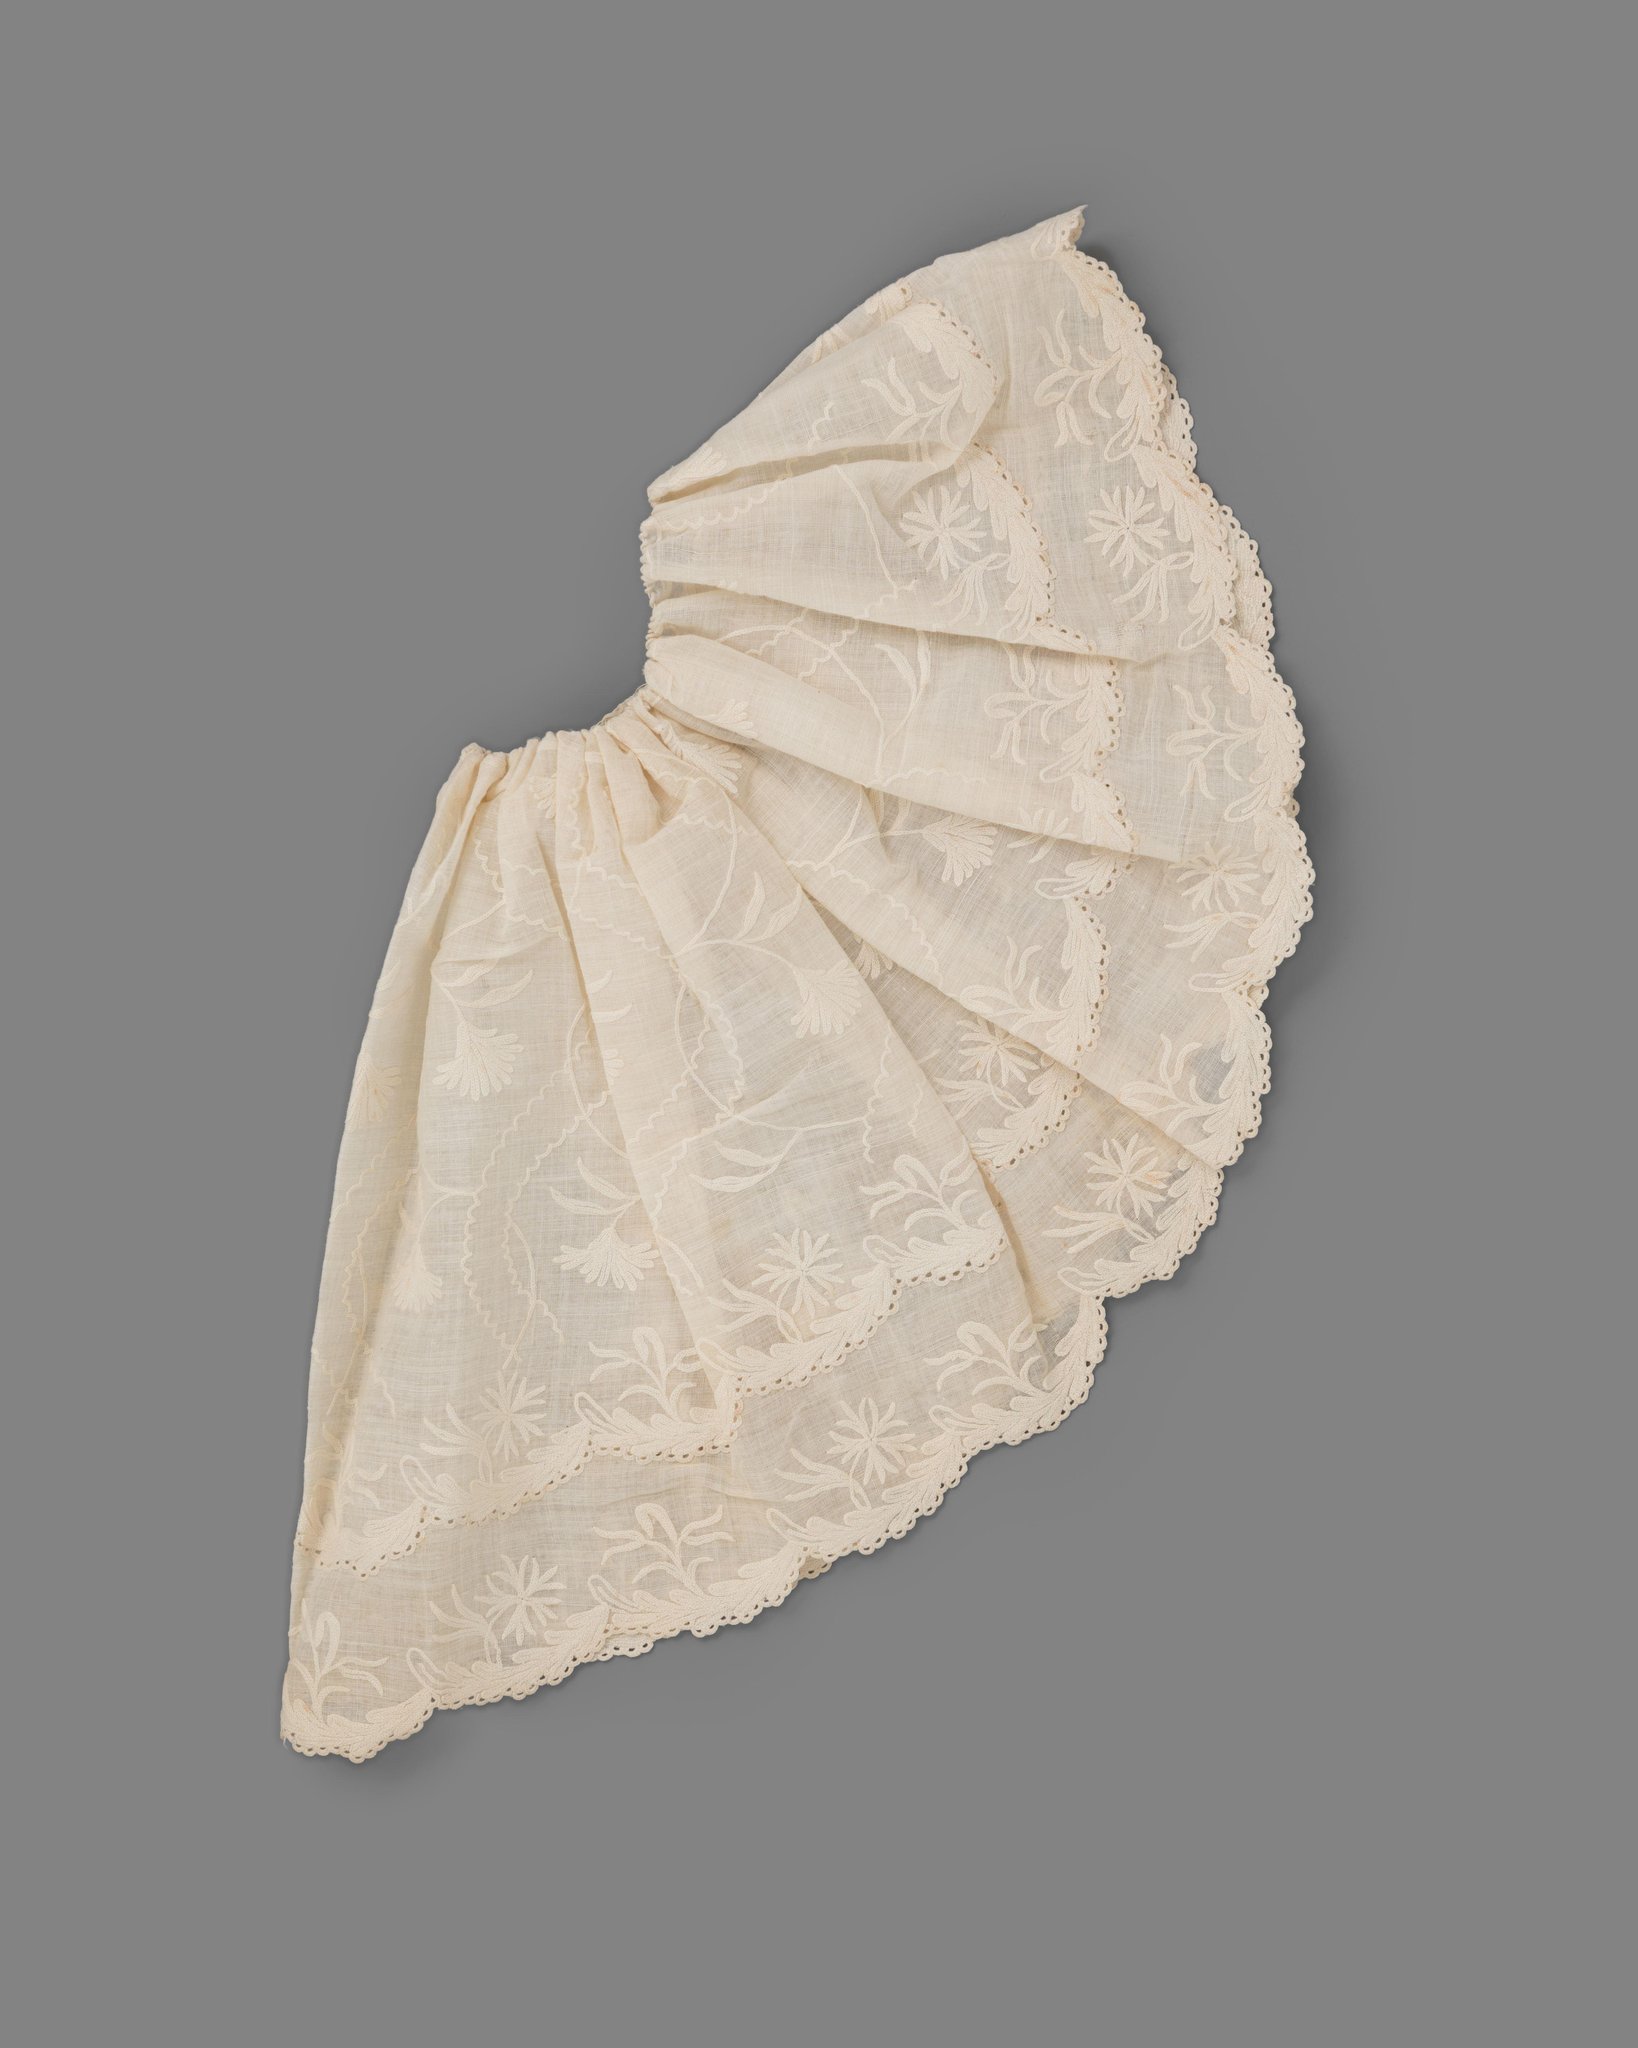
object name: engageante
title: Engageante met floraal tamboereerwerk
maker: Anonymous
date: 1750-1775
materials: linen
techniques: embroidered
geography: western europe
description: Engageante met floraal tamboereerwerk. De engageante lijkt uit twee lagen te bestaan door een tweemaal geschulpte omtrek.